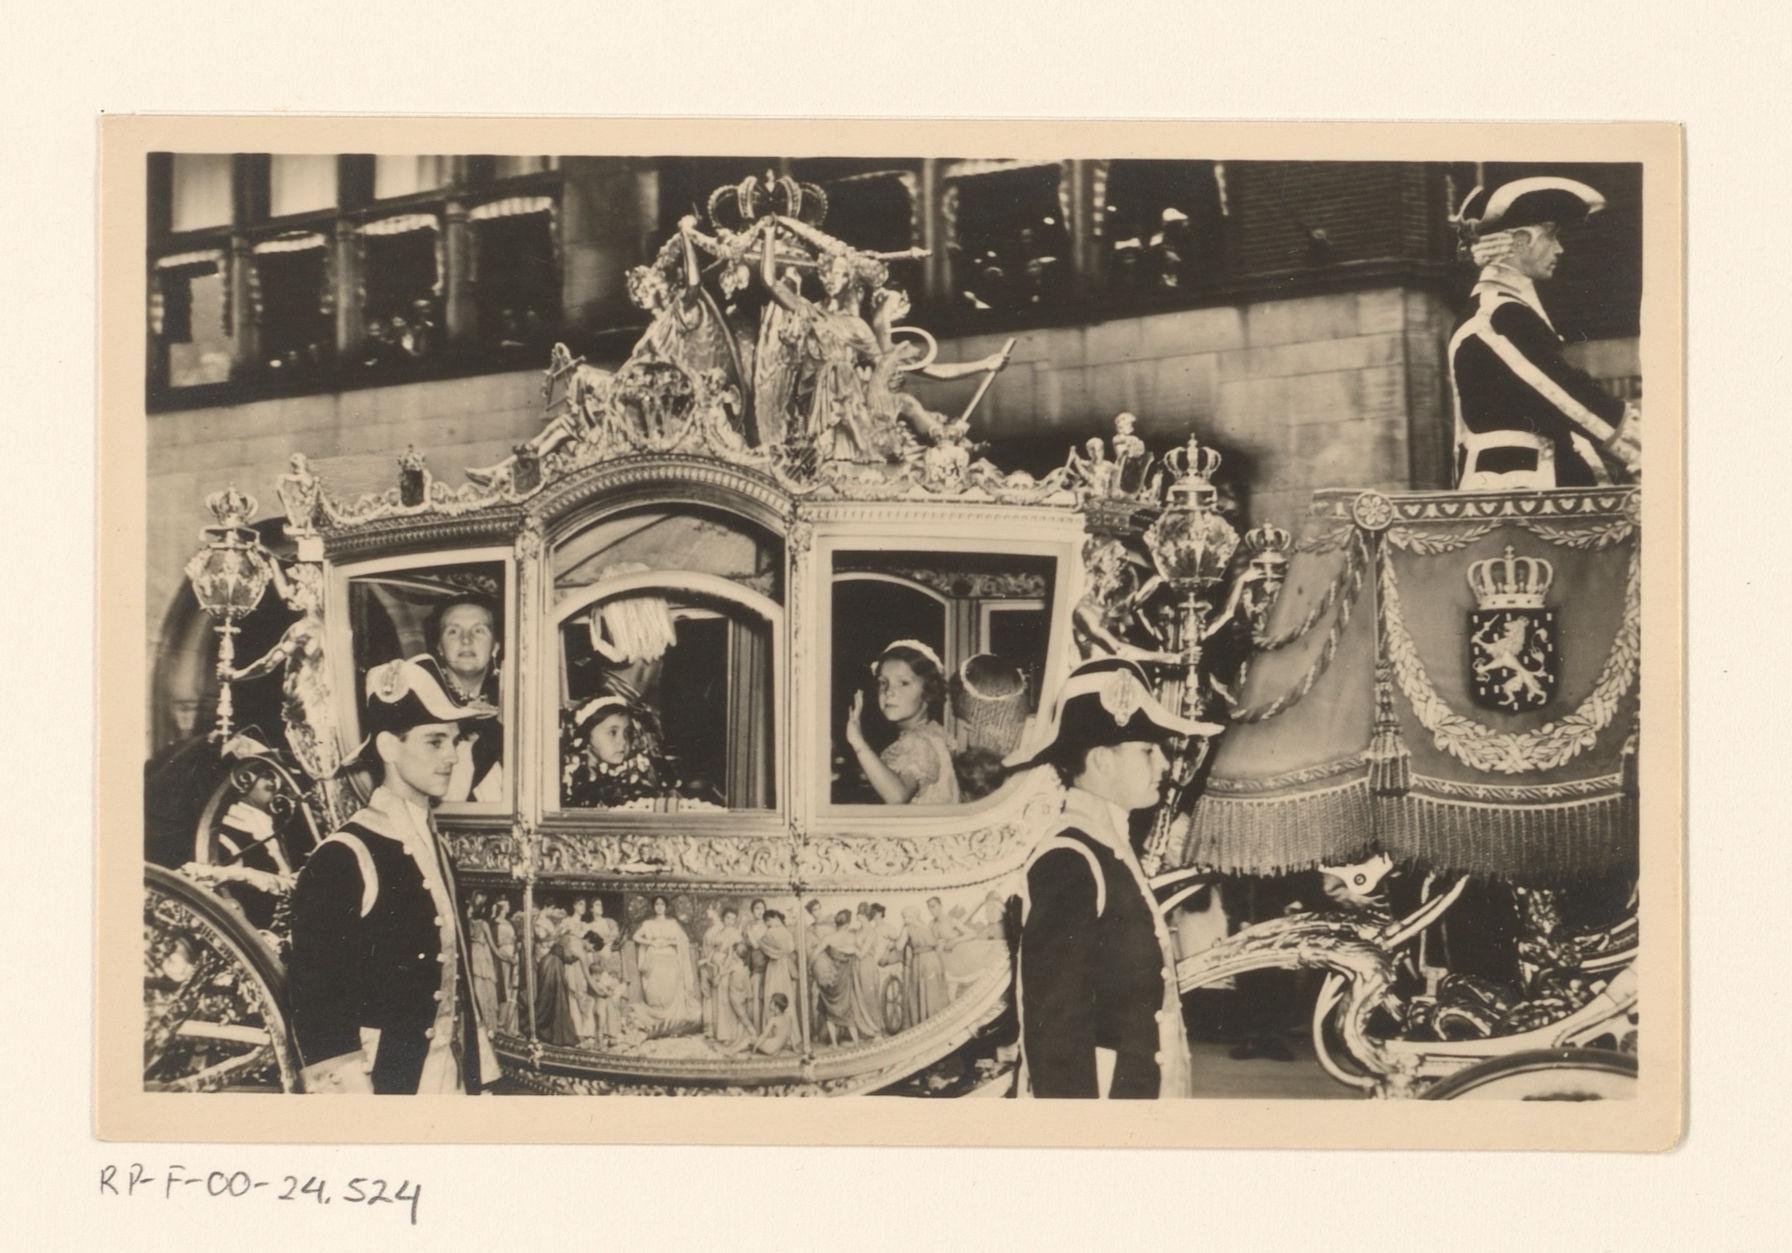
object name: photograph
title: De Gouden Koets door Amsterdam na de inhuldiging in de Nieuwe Kerk te Amsterdam / 6 September 1948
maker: Anonymous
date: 1948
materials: paper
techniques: gelatin silver print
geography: amsterdam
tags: utrecht, bernhard (prins der nederlanden), beatrix (koningin der nederlanden), the hague, juliana of the netherlands, installation of a ruler - bb - female ruler, historical persons - bb - woman, historical persons, amsterdam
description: Koningin Juliana met prins Bernhard en de prinsesjes Beatrix en Irene tijdens de rijtoer door Amsterdam in de Gouden Koets. Na de inhuldiging in de Nieuwe Kerk te Amsterdam op 6 september 1948.